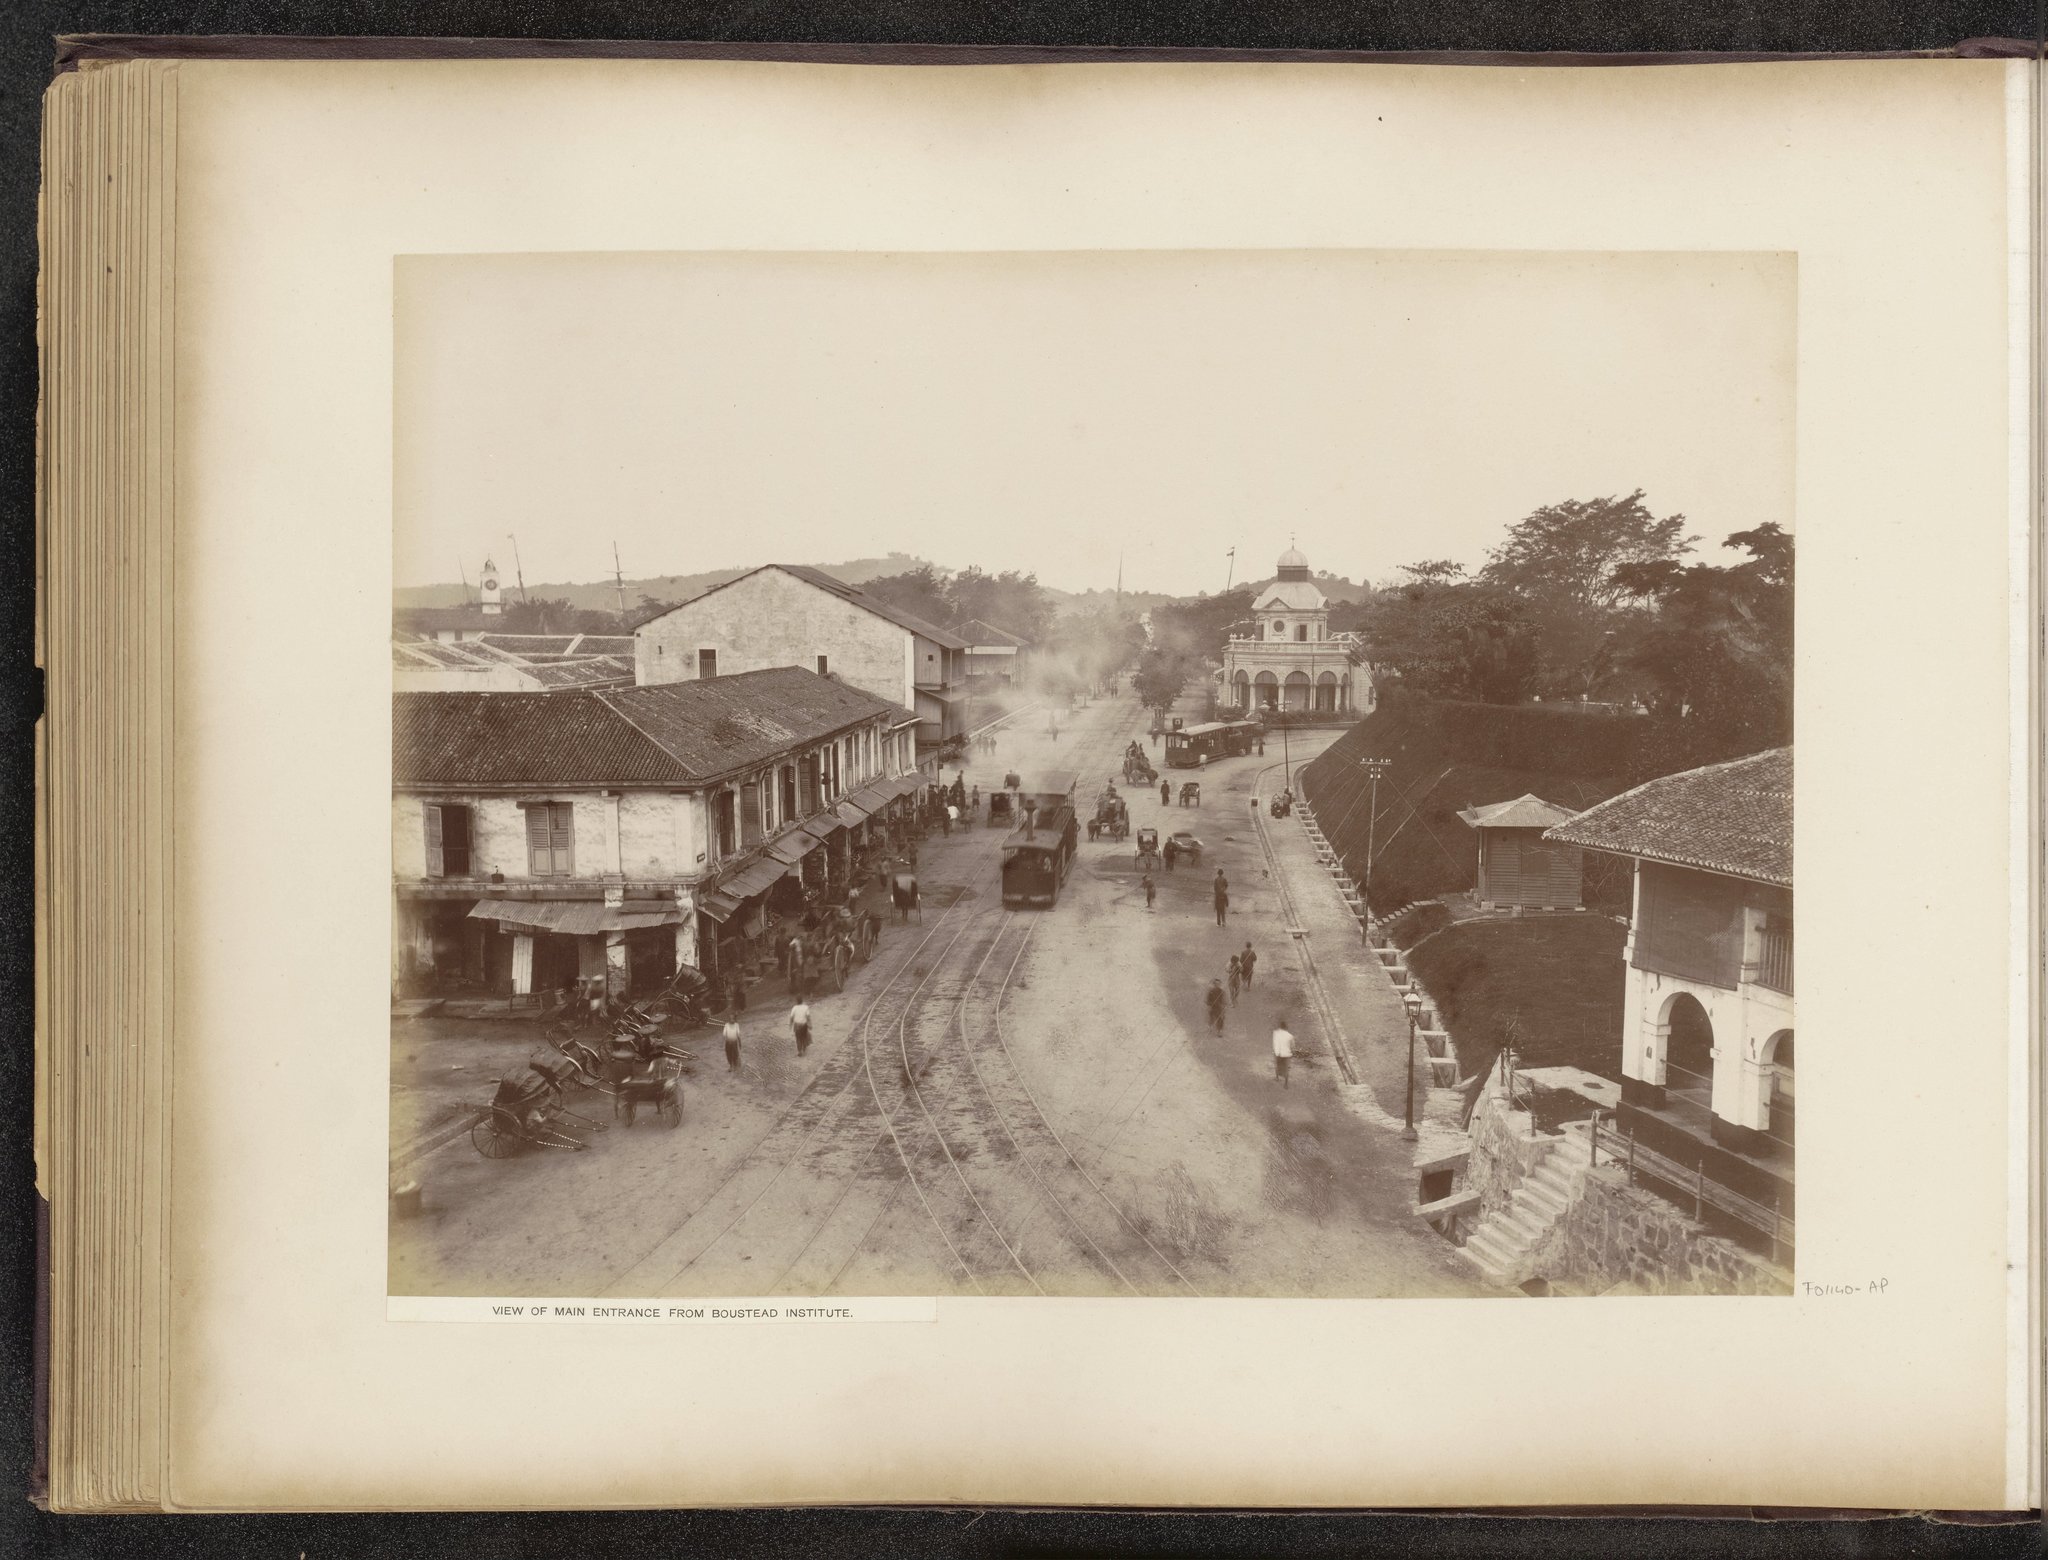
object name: photograph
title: View on main entrance from Boustead Institute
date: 1890-1905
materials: photographic support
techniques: albumen print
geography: singapore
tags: tramway, tram, gate, entrance, street (+ city(-scape) with figures, staffage), police, singapore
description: Het Boustead Institute, genoemd naar zakenman en filantroop Edward Boustead (1800–1888), was een in Tanjong Pagar gevestigd zeemanshuis voor voormalige en bezoekende zeelieden.